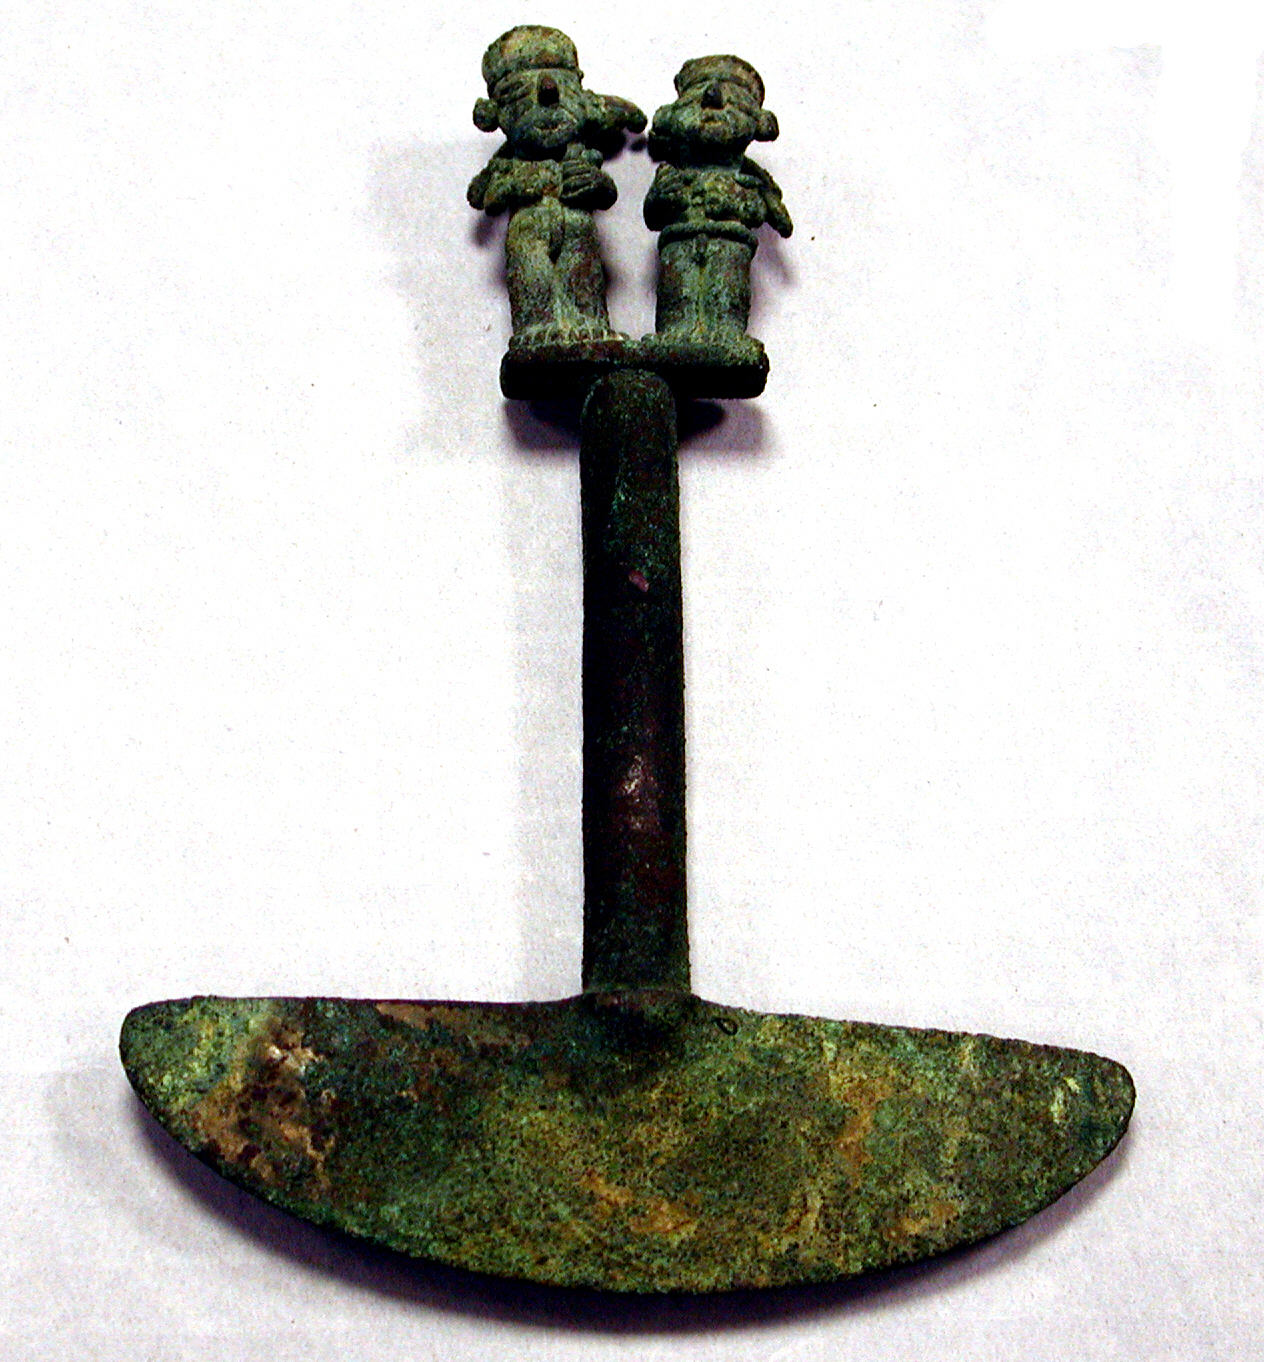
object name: knife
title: Ceremonial Knife (Tumi)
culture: inca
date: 1401-1600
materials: copper, silver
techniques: casting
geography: peru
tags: human figures